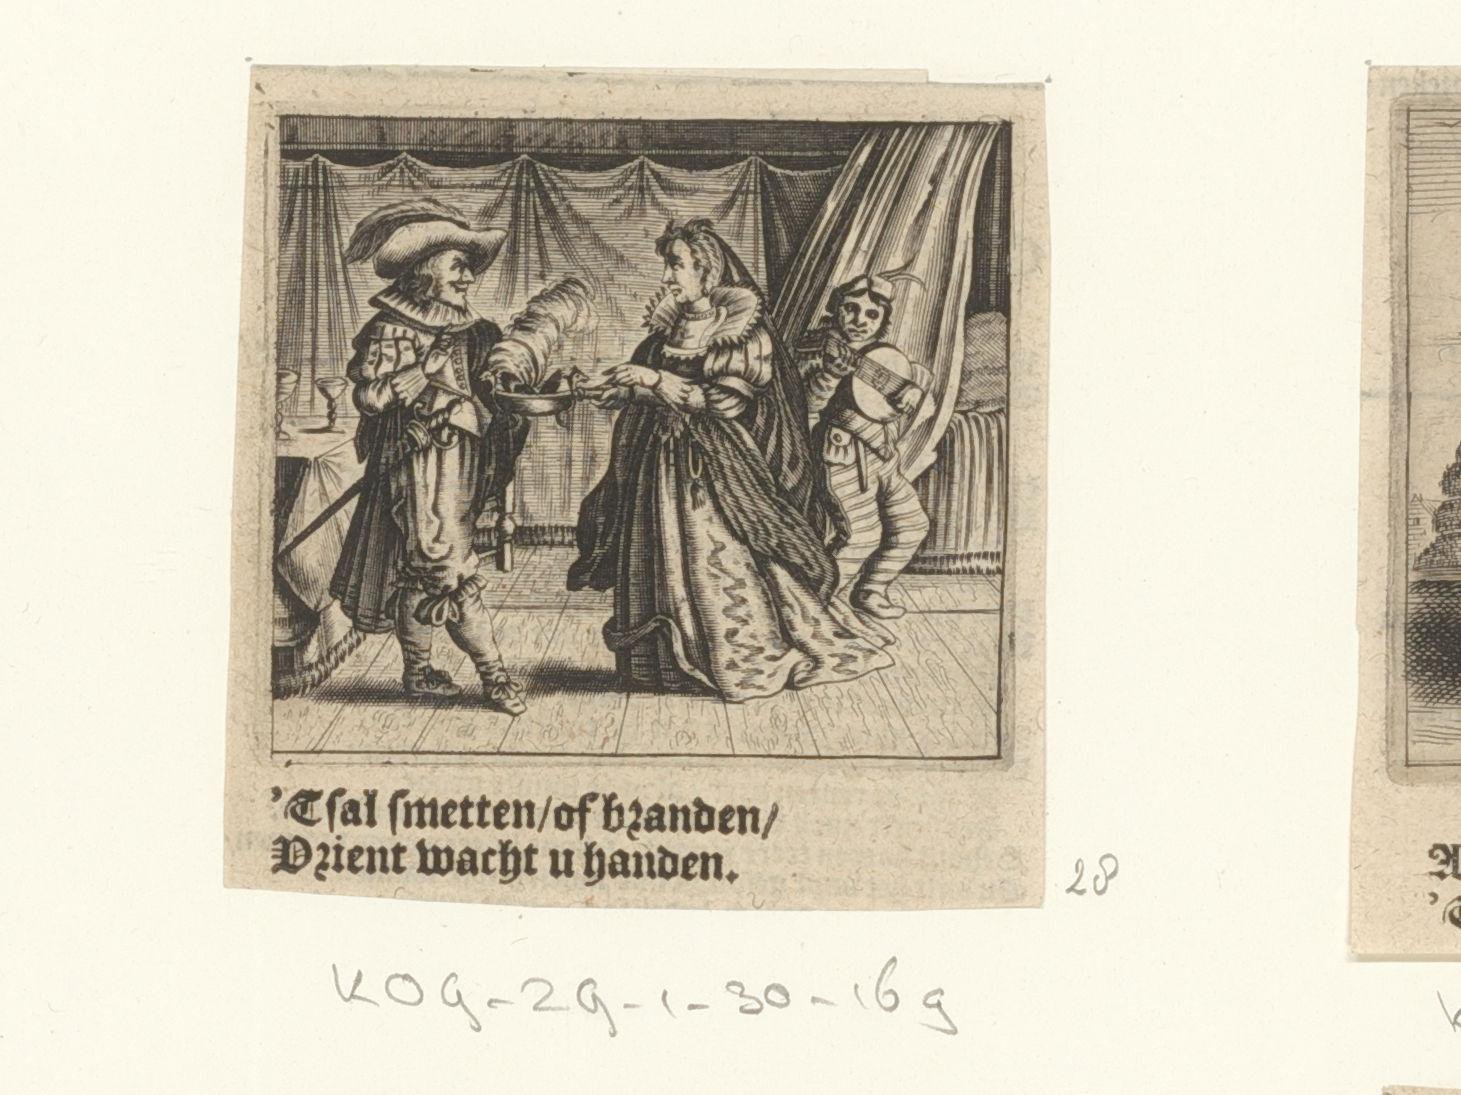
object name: book illustration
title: Man houdt schaal met brandende kolen op voor een vrouw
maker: Anonymous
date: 1635-1715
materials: paper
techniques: engraving, letterpress printing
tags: burning as process: coal, proverbs, sayings, etc., bowl, couple of lovers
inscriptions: collector's mark: Lugt 1641, stamp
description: Veel versies van dit embleem verschenen in verschillende uitgave van Spiegel van den Ouden ende Nieuwen Tydt. Zoals: Cats, Jacob. Spiegel van den Ouden ende Nieuwen-tijt, Bestaende uyt Spreeck-woorden (...). Dordrecht: Jacob Braat, 1647. Maar ook in andere publicaties (1665, 1671, 1715, 1722).